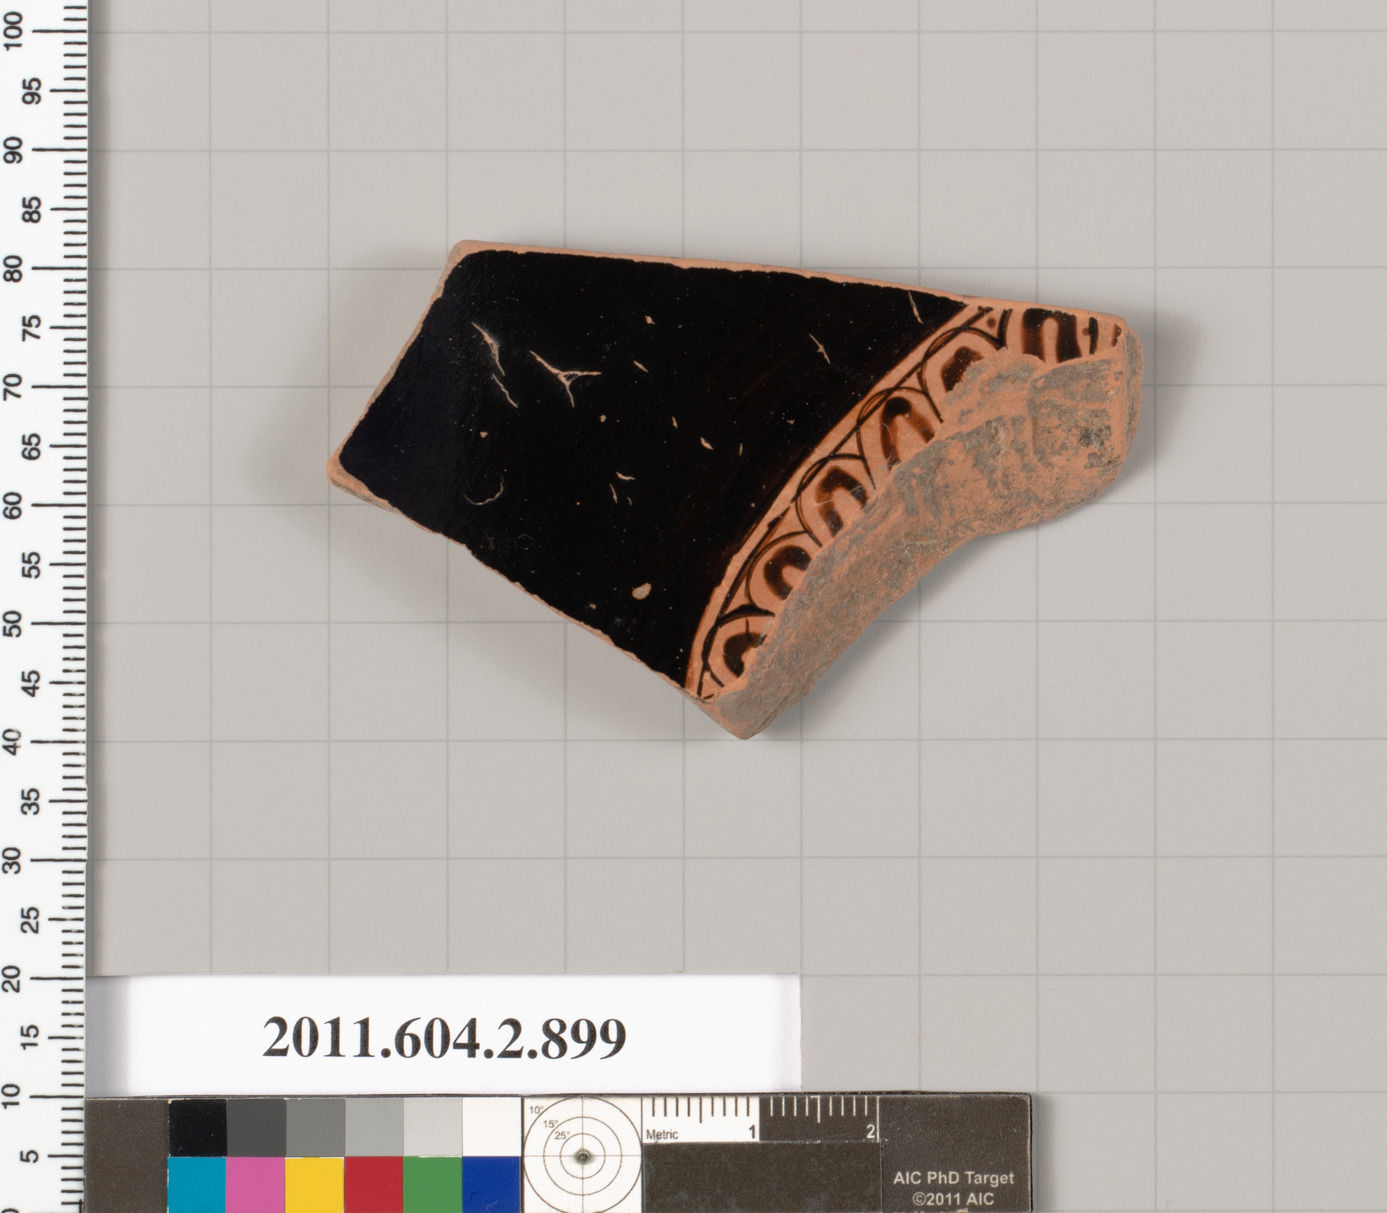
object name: bell krater fragment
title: Terracotta fragment of a bell-krater (bowl for mixing wine and water)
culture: greek, attic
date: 450-440 BCE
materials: terracotta